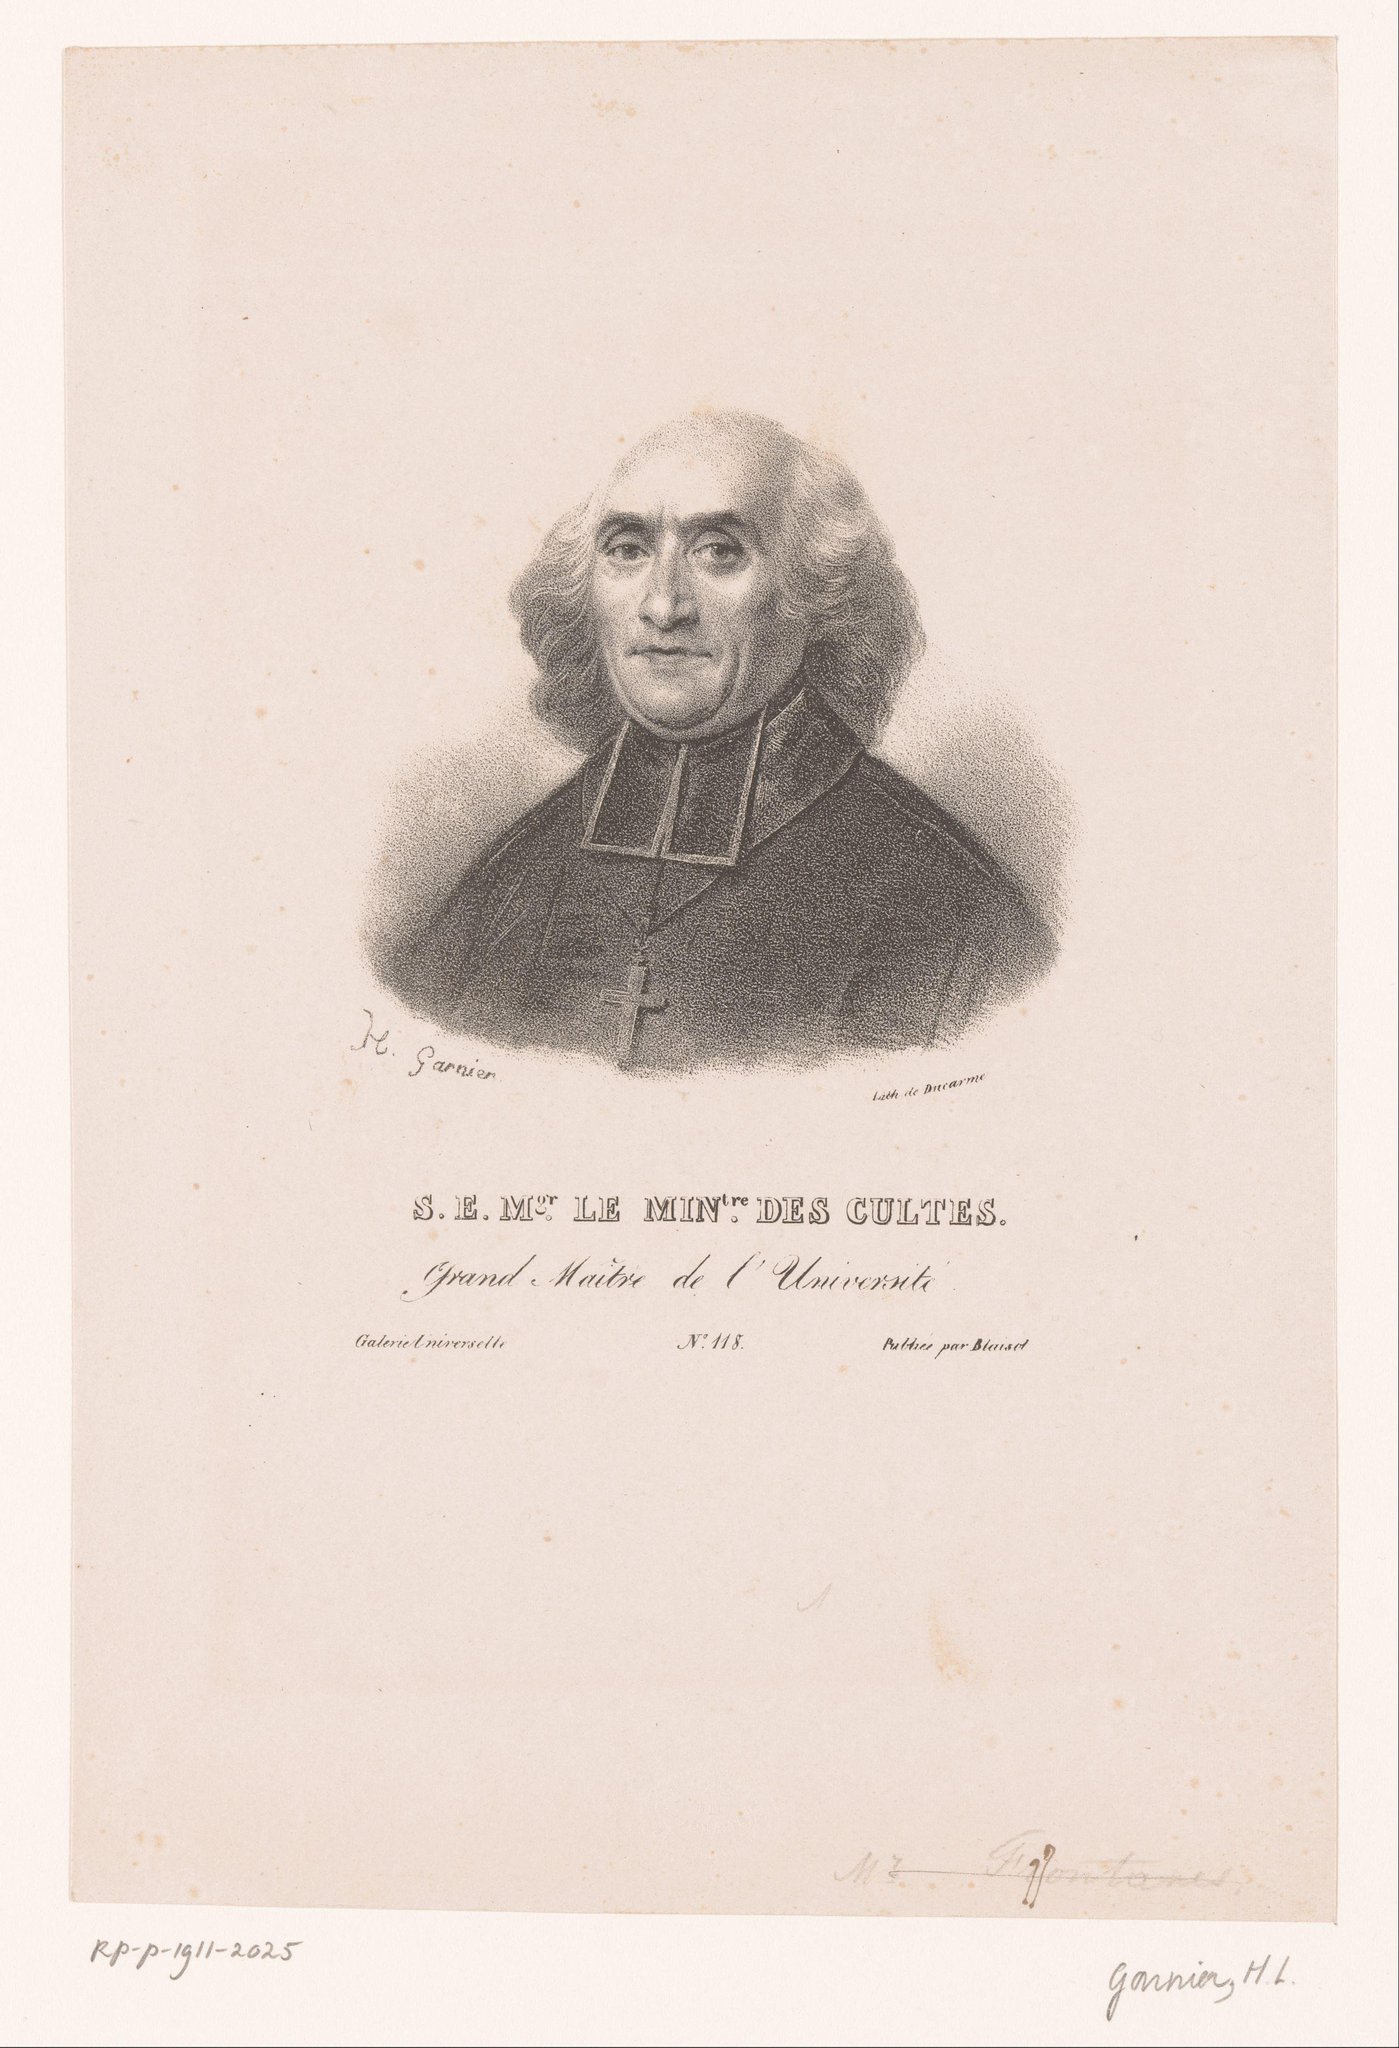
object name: print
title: Portrettengalerij van Blaisot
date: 1823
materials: paper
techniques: lithograph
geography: paris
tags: politician, historical persons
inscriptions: check stamp: ‘Gbr. Gropius. / Im Diorama / In Berlin’ Lugt, collector's mark: Lugt 2228a